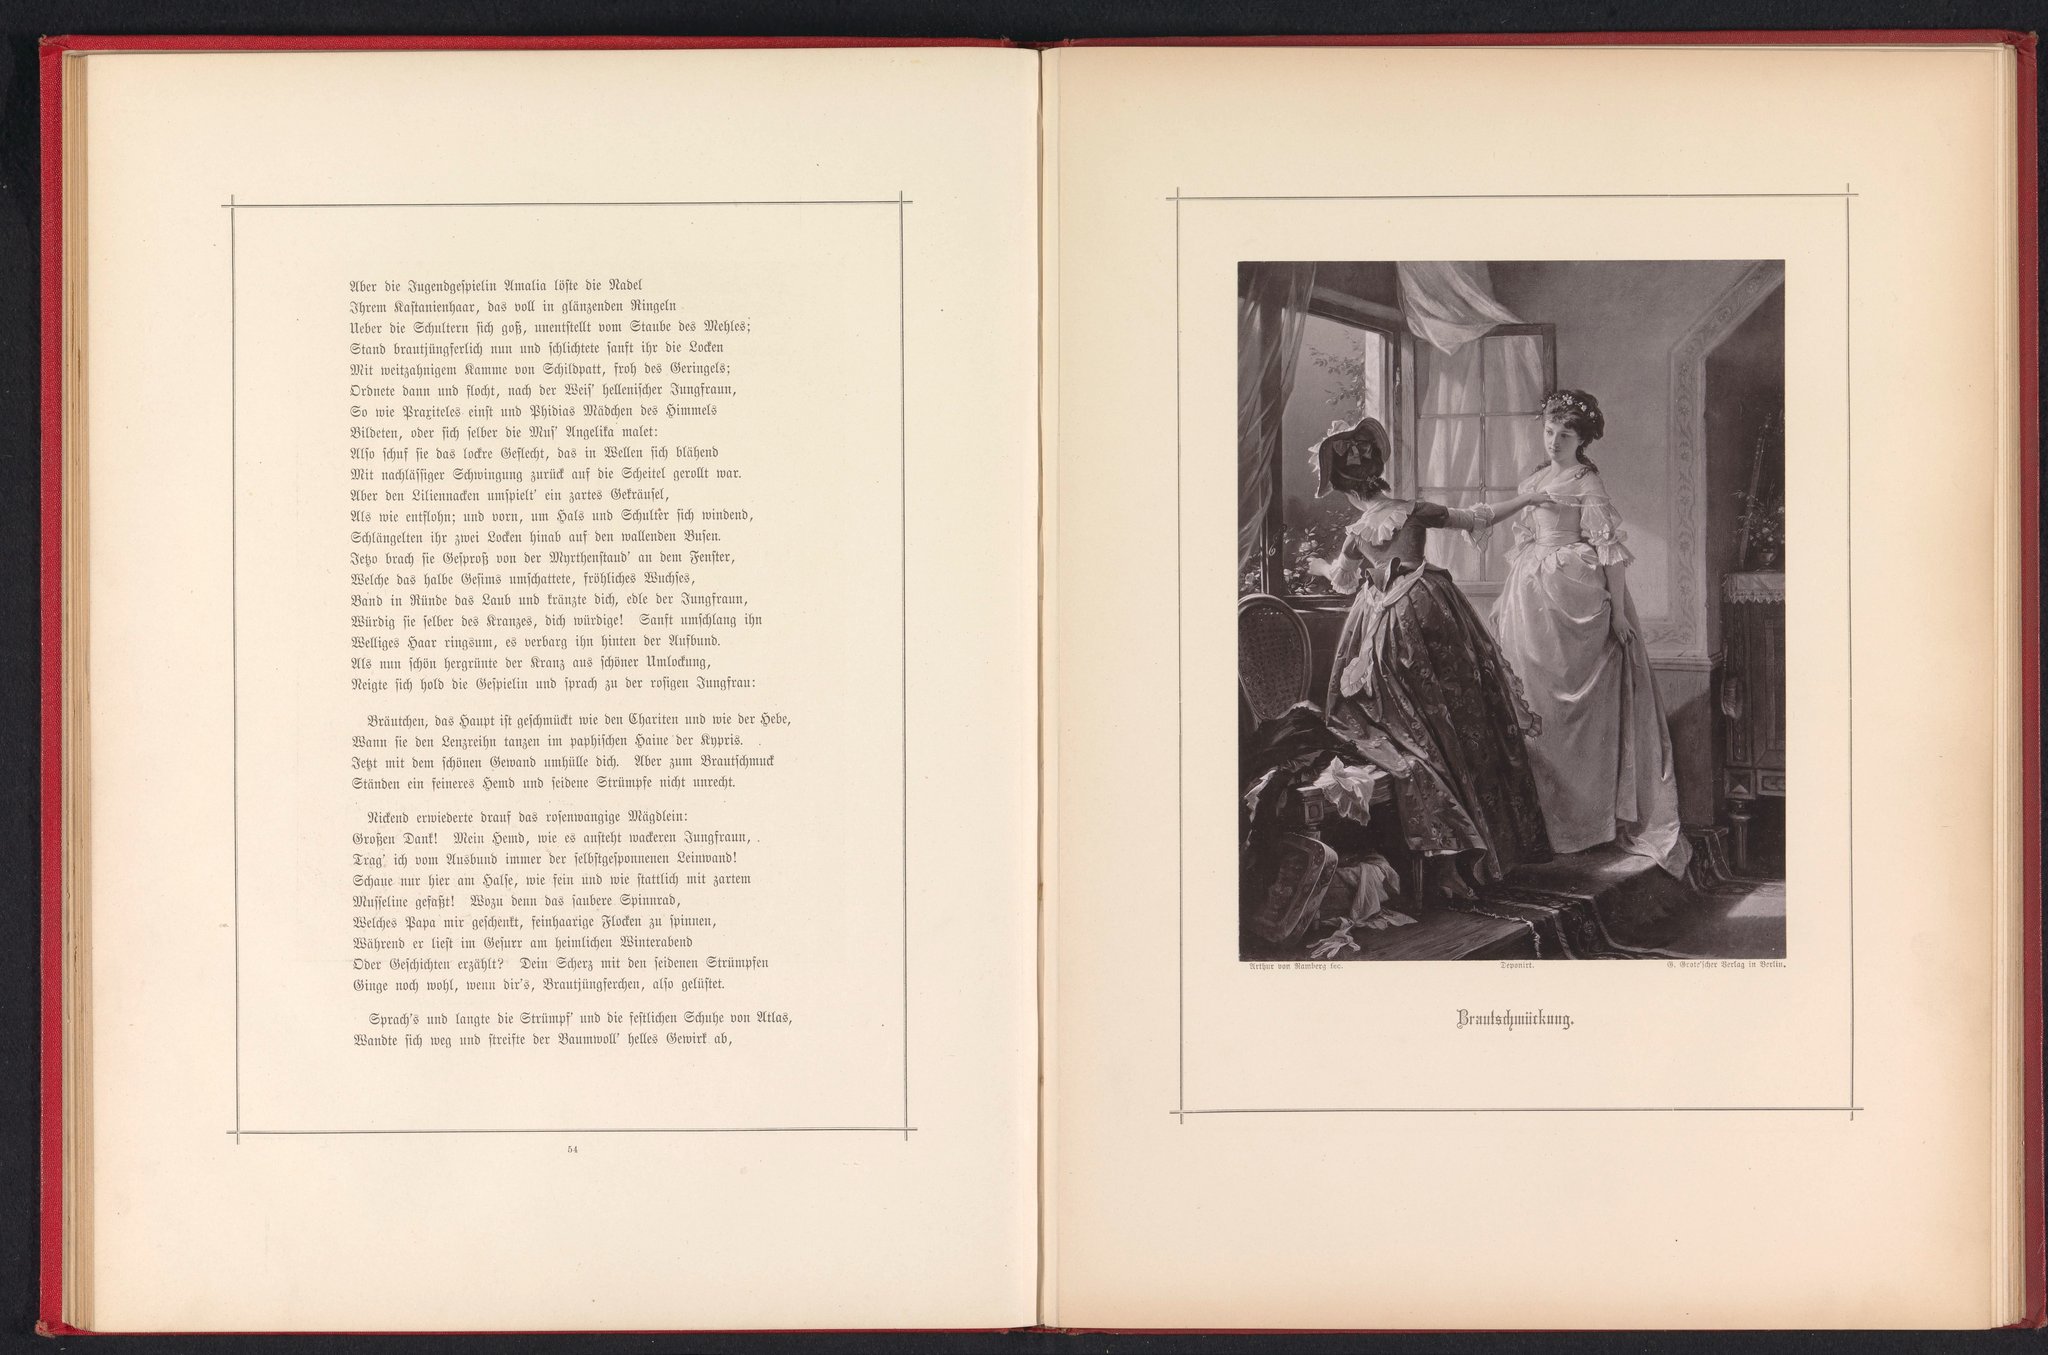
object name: reproduction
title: Brautschmückung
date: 1874-1884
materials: paper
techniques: photograph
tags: dressing the bride